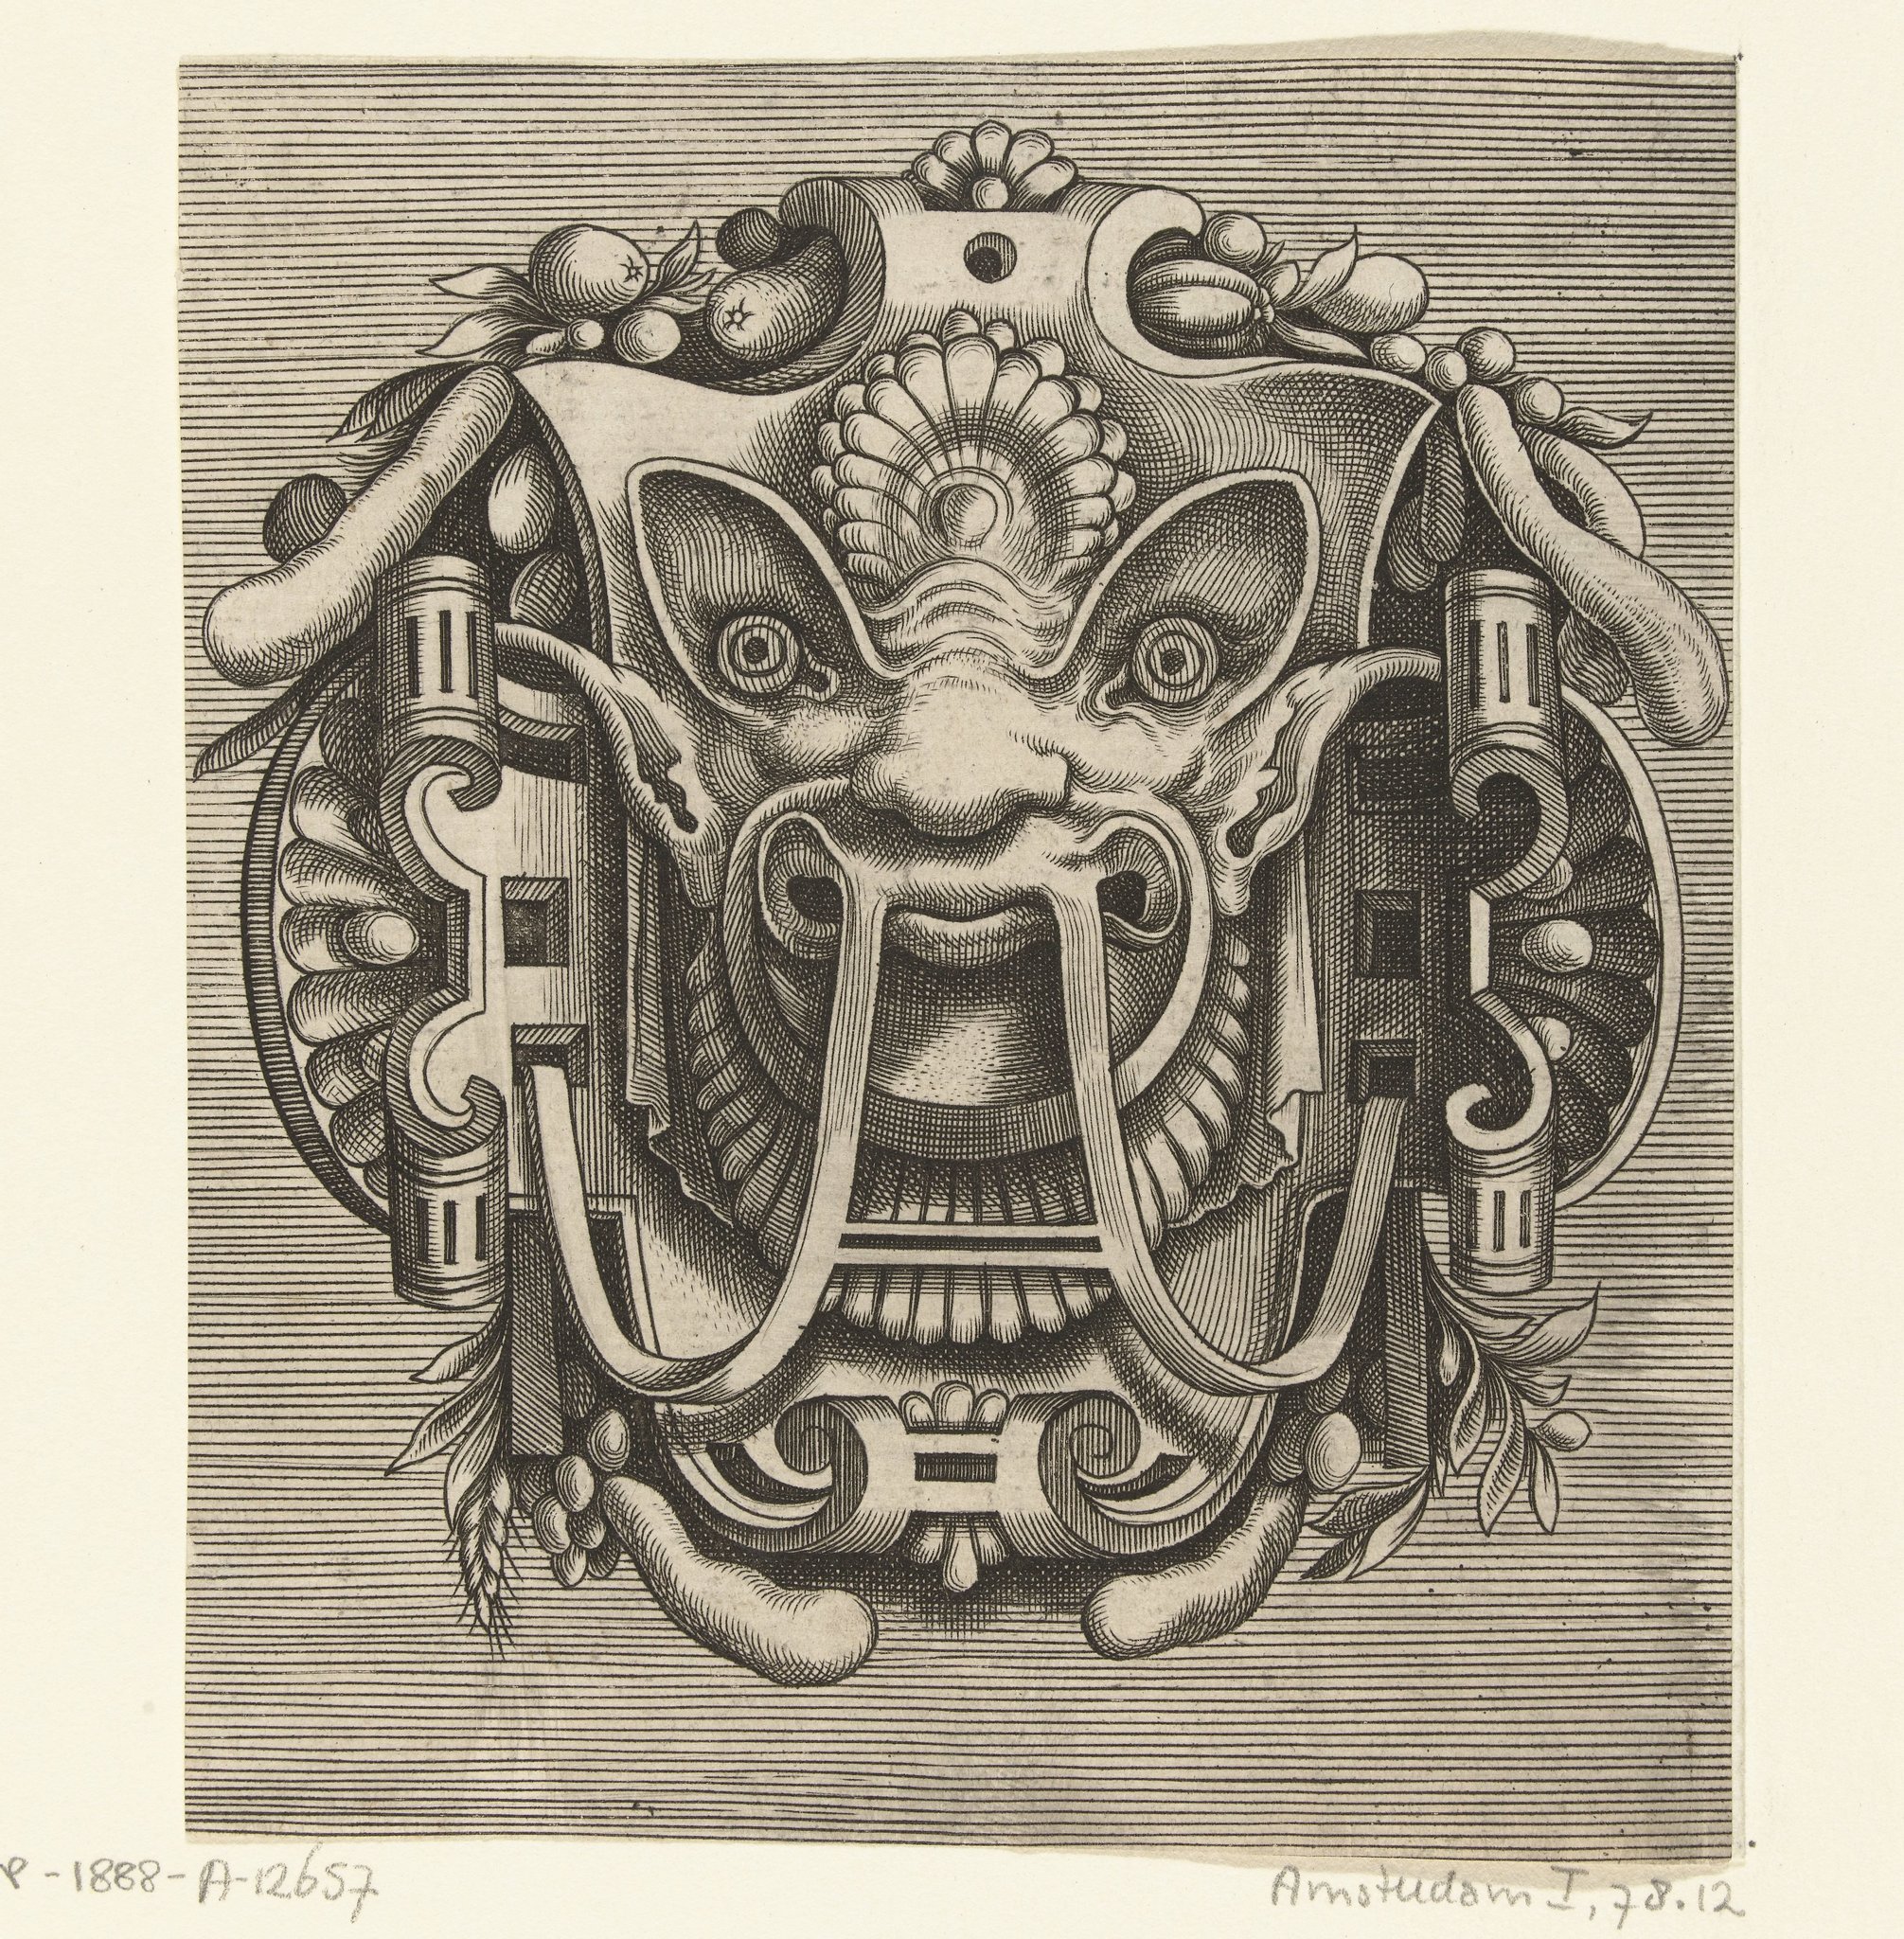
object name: print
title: Pourtraicture ingenieuse de plusieurs facons de masques…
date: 1555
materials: paper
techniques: engraving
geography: antwerp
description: Op het hoofd liggen vruchten. De lippen lopen uit in linten. Een van 14 bladen uit een serie van 18 met als titel 'Pourtraicture ingenieuse de plusieurs façons de masques...'. Het titelblad ontbreekt.